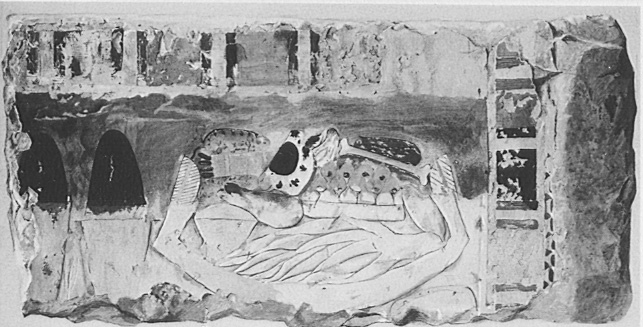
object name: facsimile, perneb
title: Offerings, Mastaba of Perneb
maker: hazel de berard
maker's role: artist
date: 2381-2323 BCE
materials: paper, paint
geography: egypt